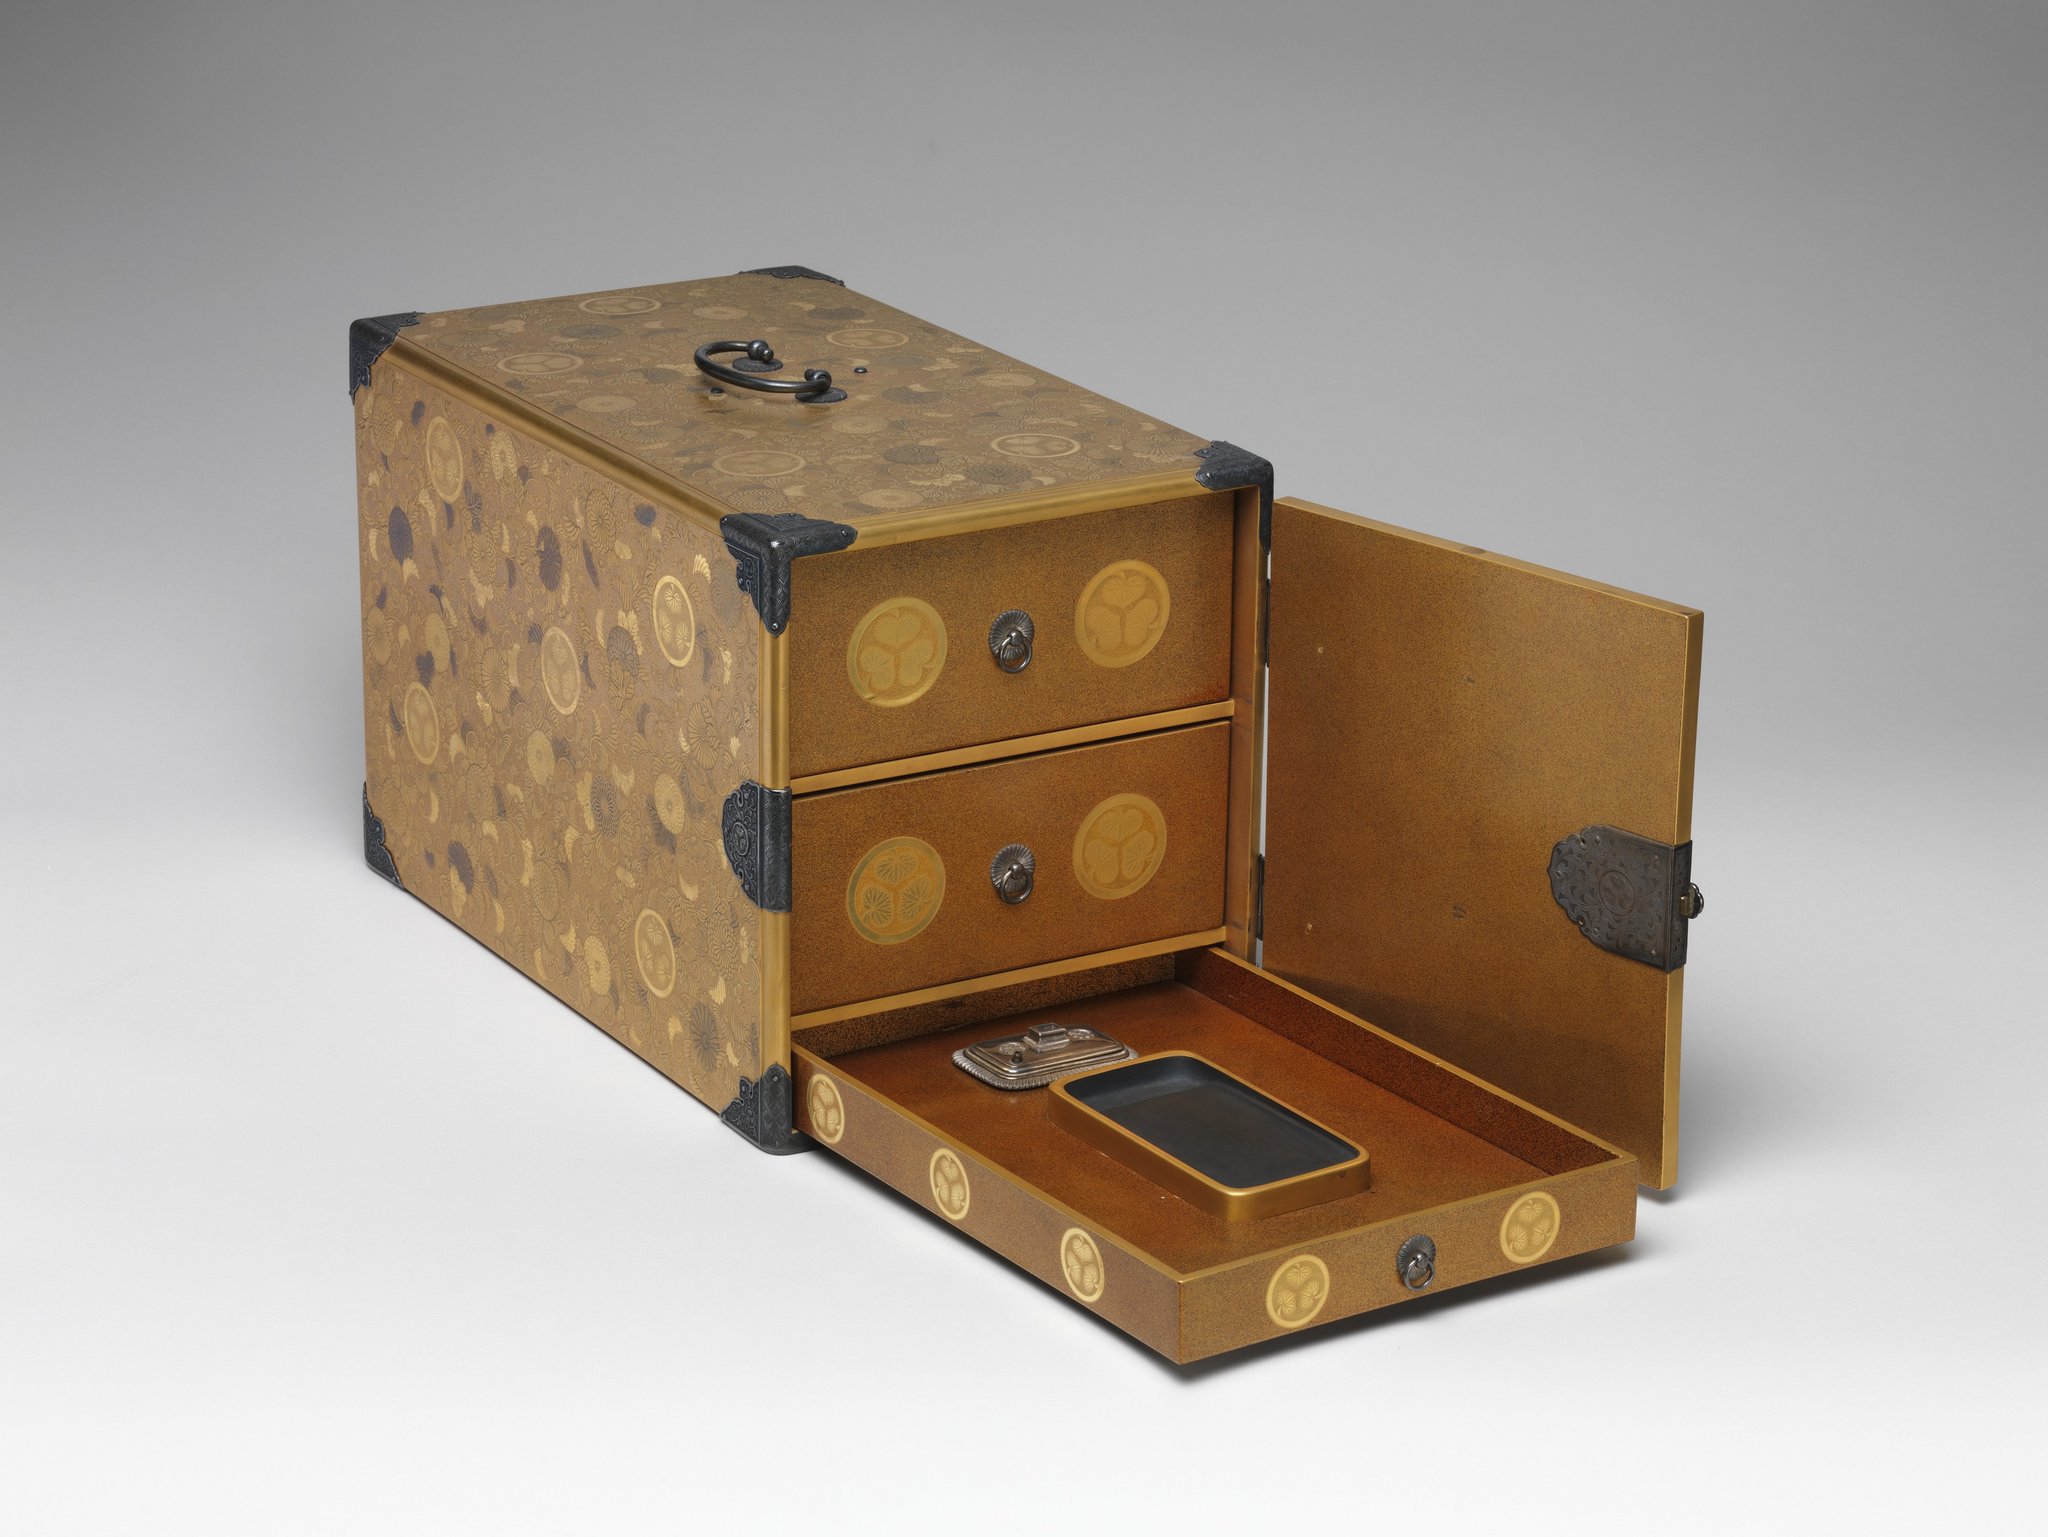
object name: cabinet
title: Portable Writing Cabinet with Tokugawa Family Crests, Chrysanthemums, and Foliage Scrolls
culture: japanese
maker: kōami school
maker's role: artist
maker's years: 1750-1799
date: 1667-1700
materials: gold, gold foil, silver, wood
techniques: hiramakie, lacquer, maki-e